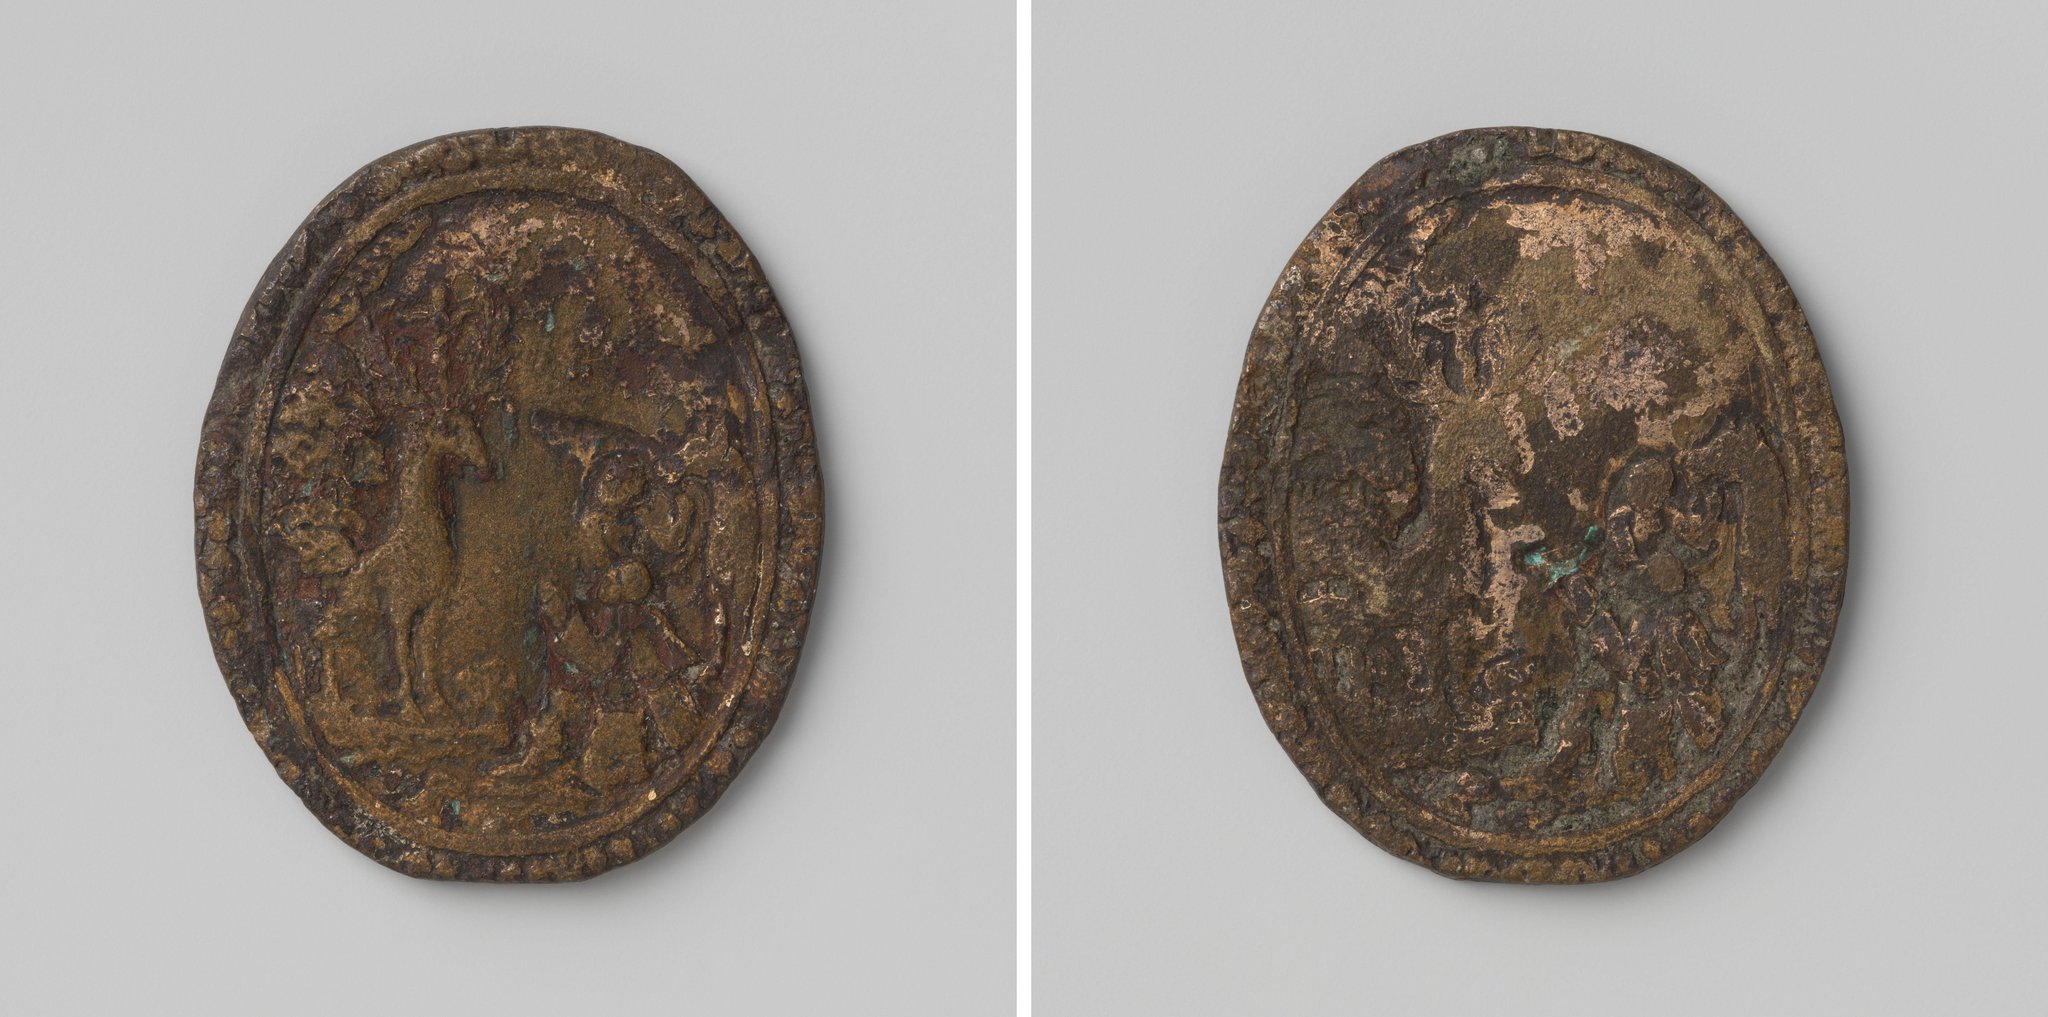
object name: medal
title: St. Hubertus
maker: Anonymous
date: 1550-1750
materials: copper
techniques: casting, gilding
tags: the hunter hubert(us), bishop of maastricht and liège; possible attributes: hounds, hunting horn, key, stag with crucifix, (bishop's) stole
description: Koperen ovale penning. Voorzijde: man met paard naast zich, kijkend naar hert met kruisteken tussen gewei. Keerzijde: man met paard naast zich, kijkend naar hert met kruisteken tussen gewei